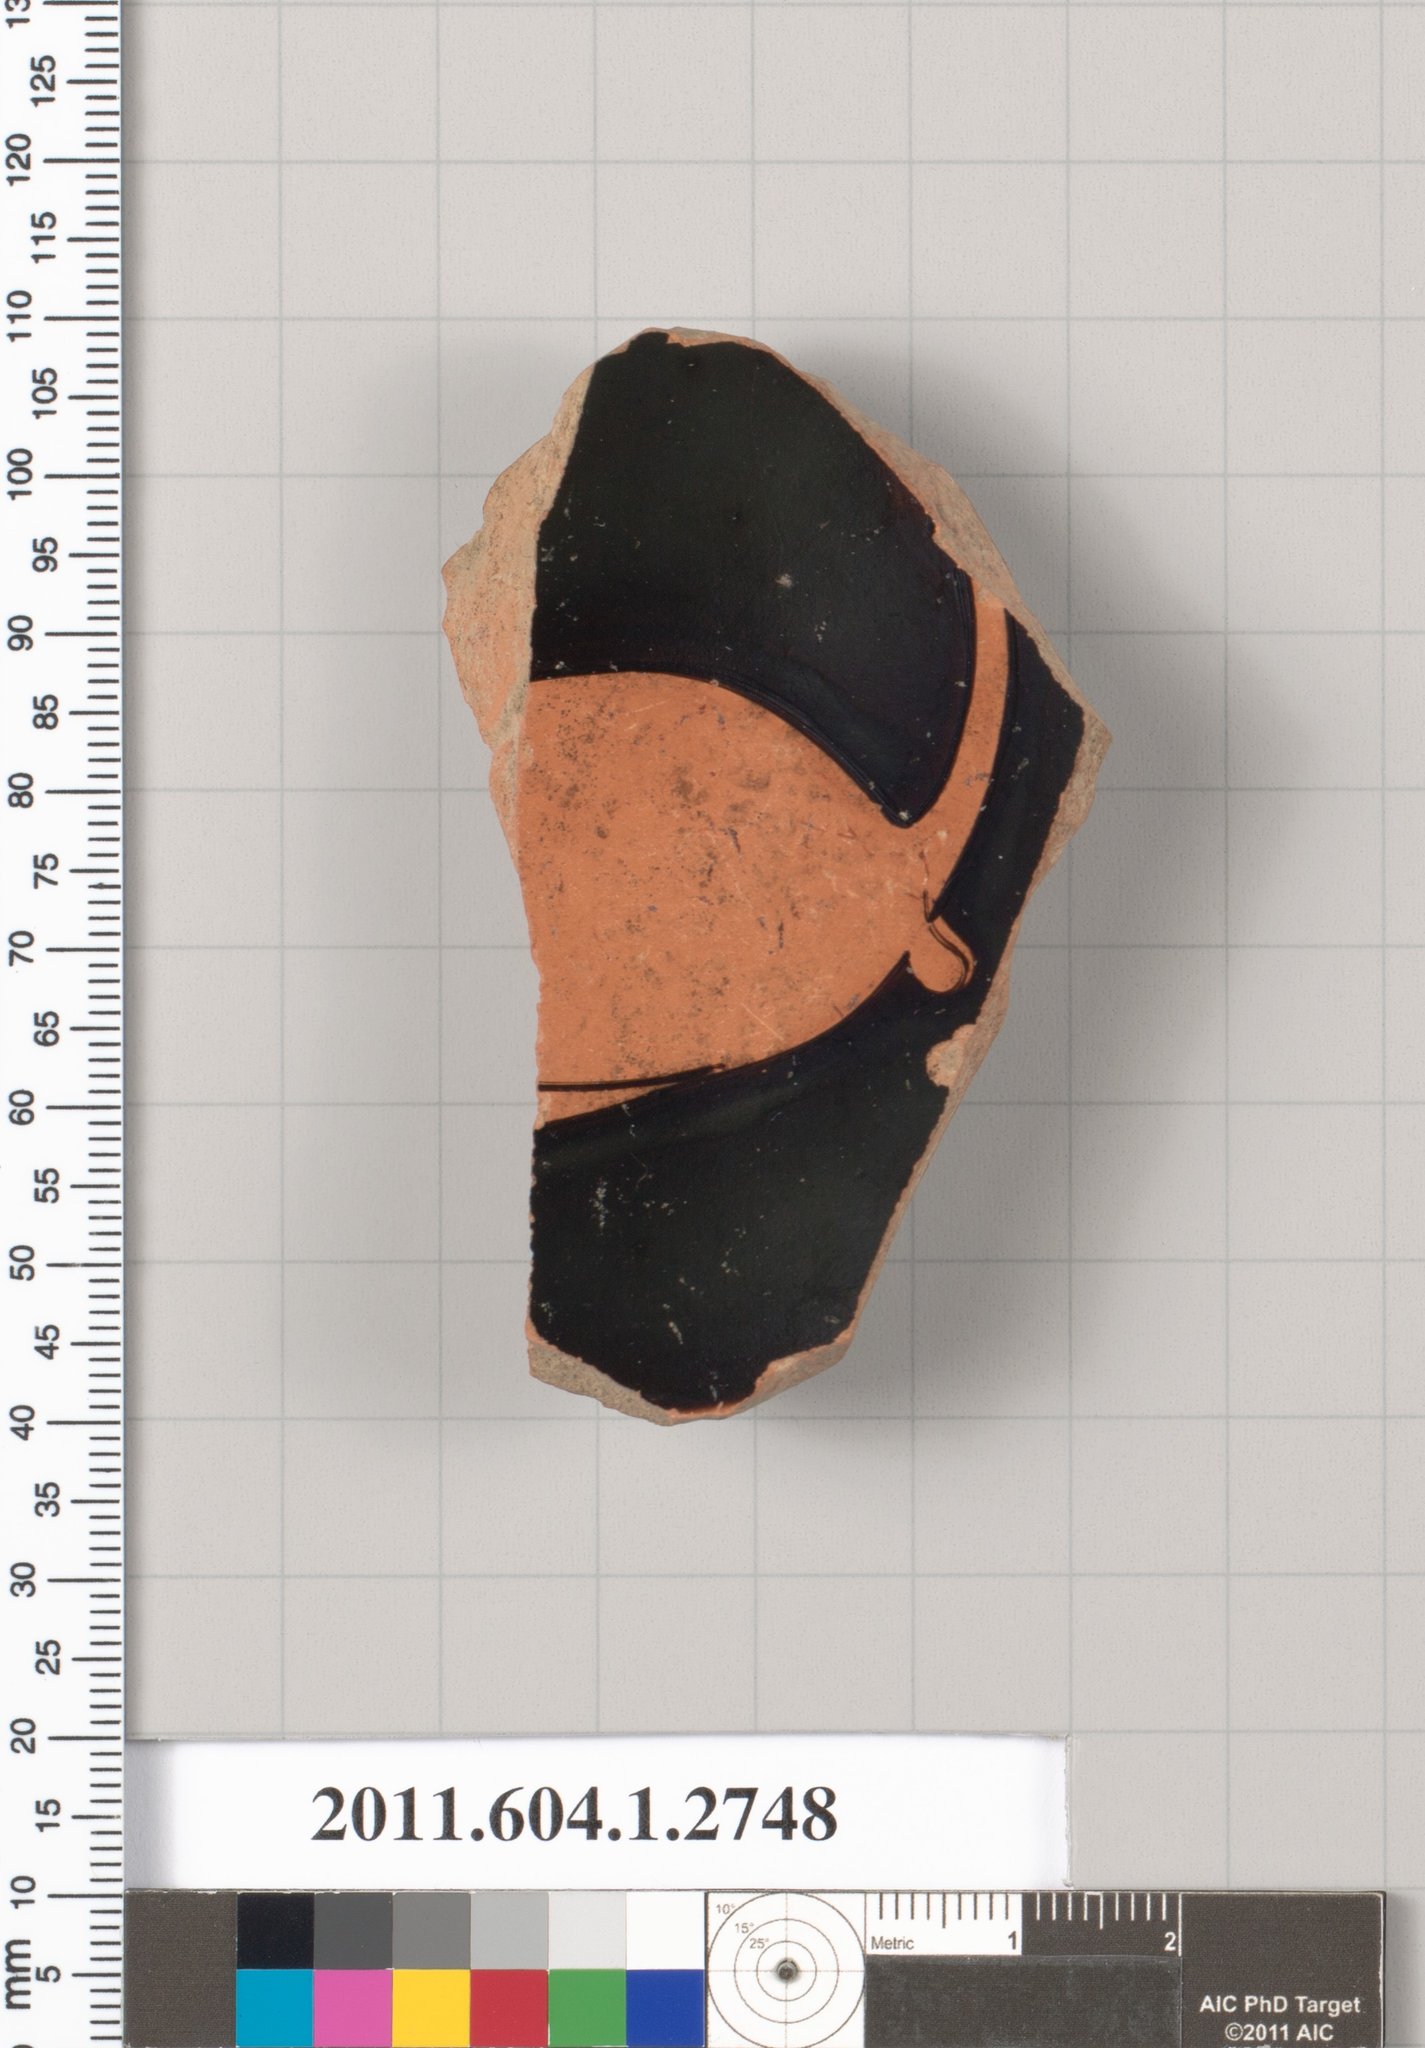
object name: kylix fragment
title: Terracotta fragment of a kylix (drinking cup)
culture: greek, attic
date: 500-480 BCE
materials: terracotta